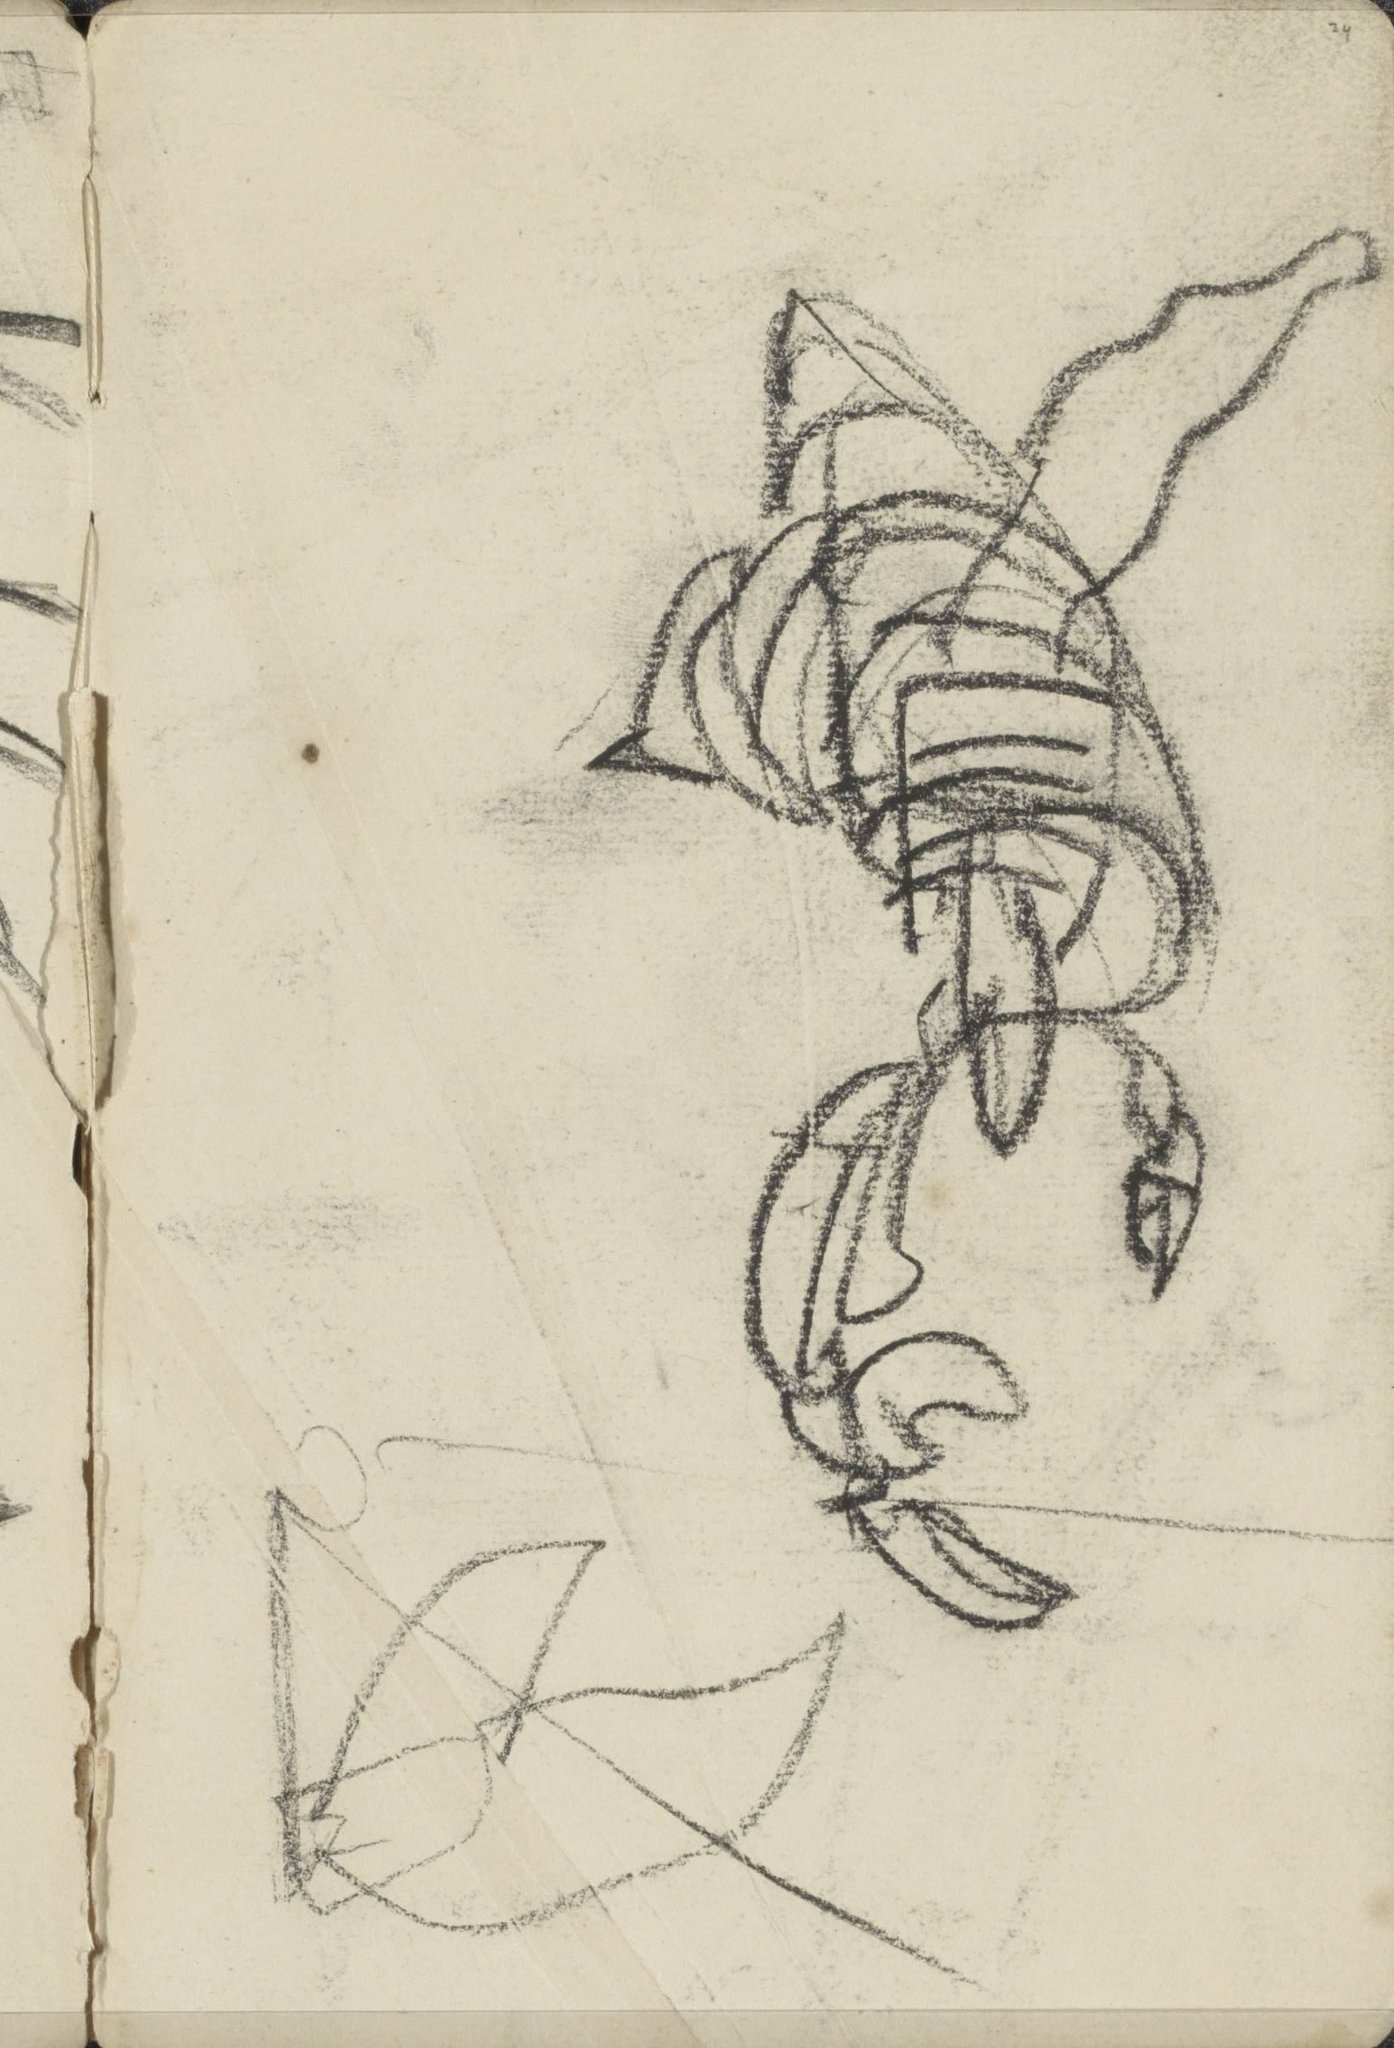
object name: sketchbook leaf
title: Studies van een kreeft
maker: george hendrik breitner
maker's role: draughtsman, painter, print maker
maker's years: 1857-1923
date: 1886-1923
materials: chalk, paper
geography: amsterdam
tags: crustaceans: lobster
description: Pagina 24 uit een schetsboek met 13 bladen.